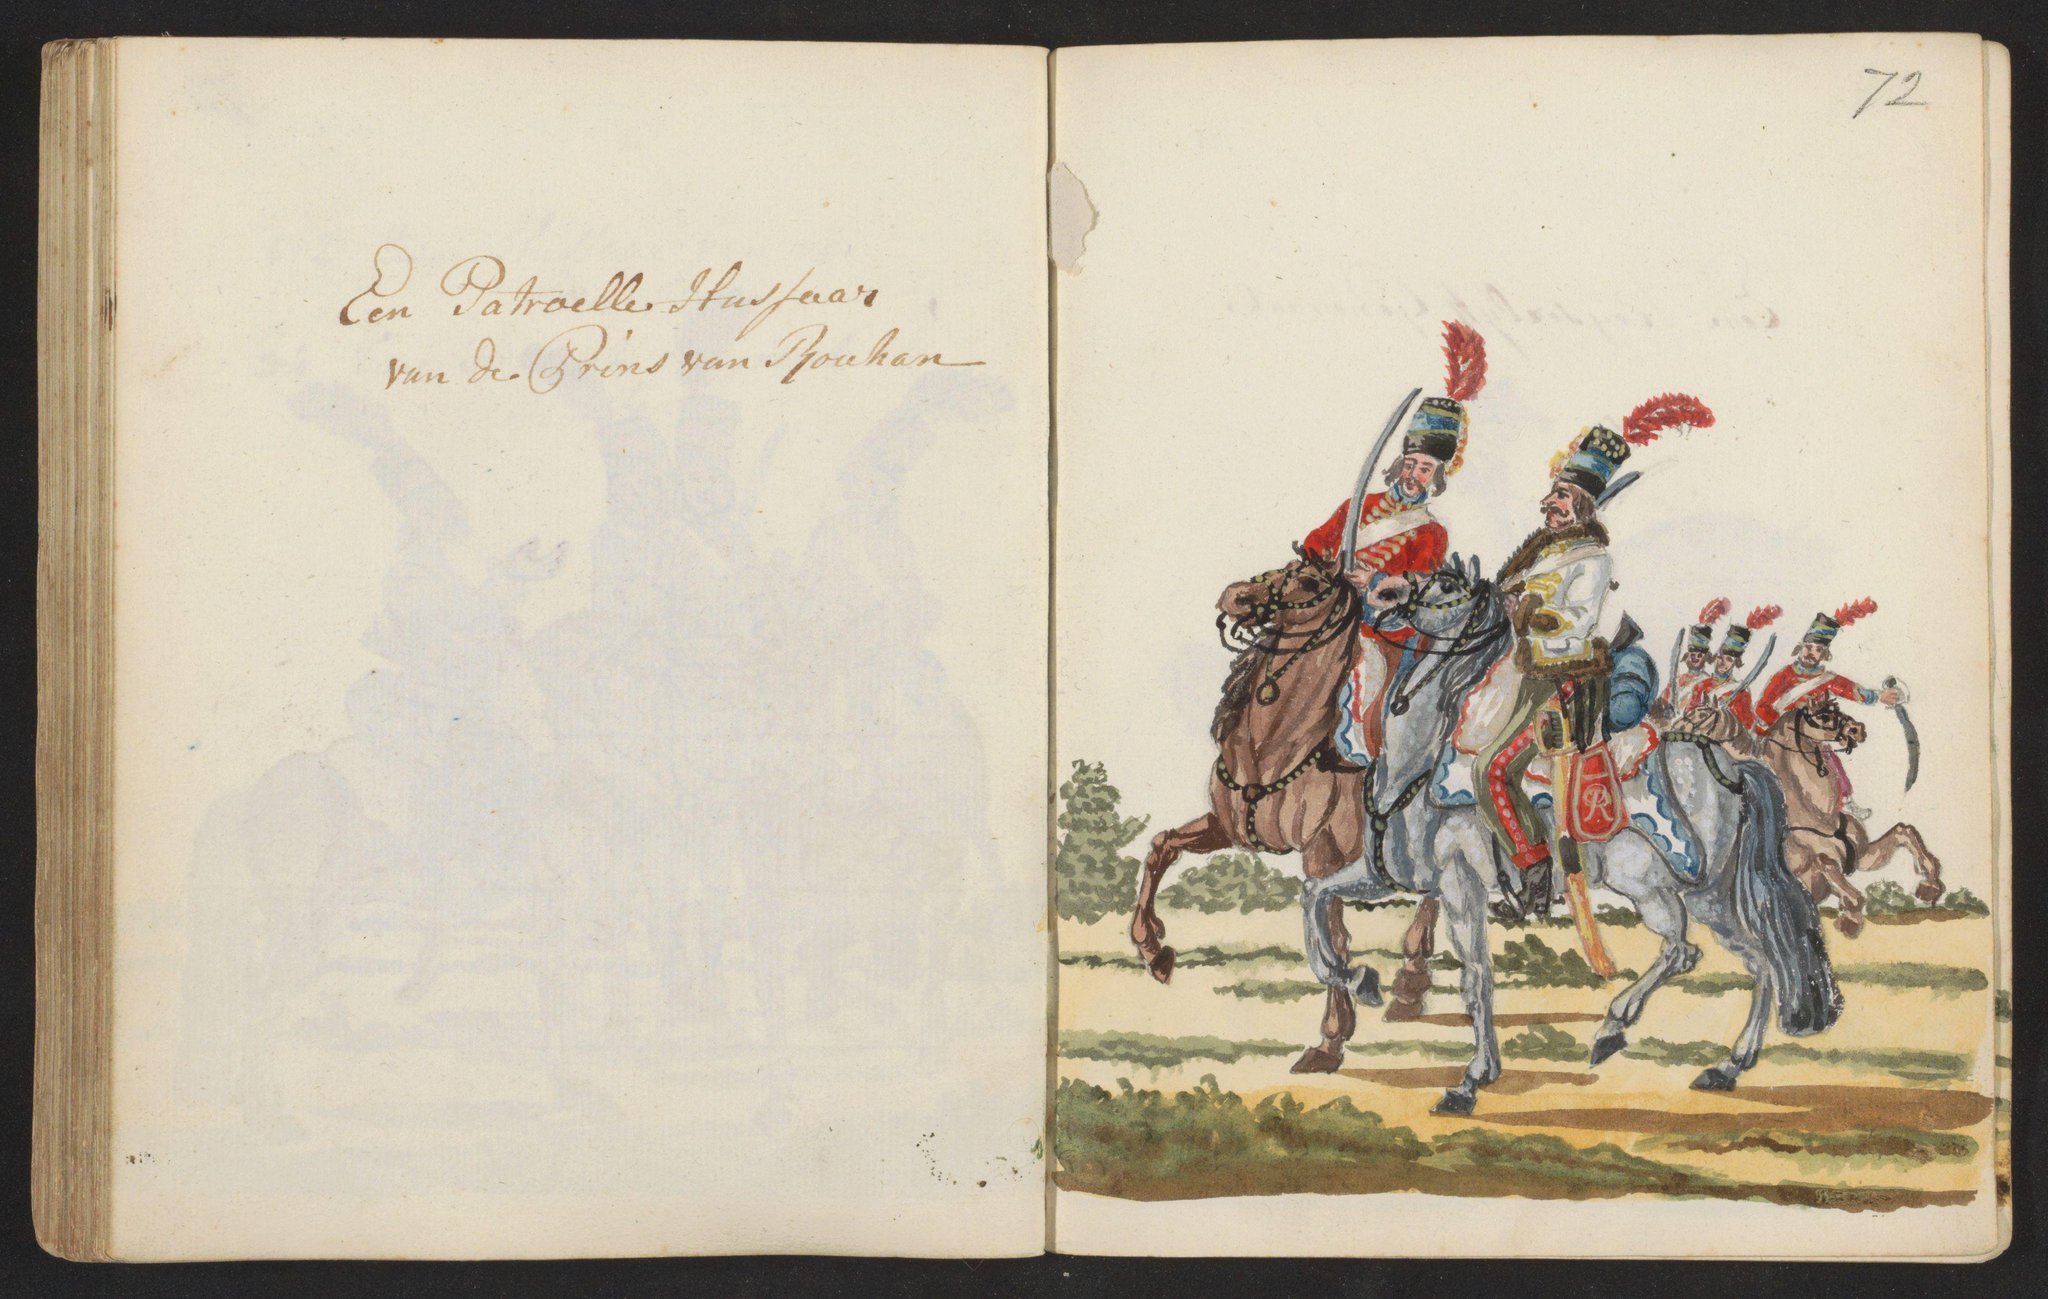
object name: drawing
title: Uniform van de huzaren van Prins Rohan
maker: s.g. casten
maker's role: draughtsman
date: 1795-1796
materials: paper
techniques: writing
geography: amsterdam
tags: (military) uniforms (+ infantry), patriots (1780-1795)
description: De uniformen van een patrouille van Franse cavaleristen van de Franse Emigranten, Korps van de Prins van Rohan, ca. 1788-1795. Onderdeel van het derde hoofdstuk over de nieuwe uniformen in de periode na het herstel van de prins van Oranje en de komst van de Pruisische troepen in Holland in 1787. In het schetsboek met gekleurde tekeningen van de uniformen van militairen en leden van de schutterij uit de periode 1770 tot 1795-1796.